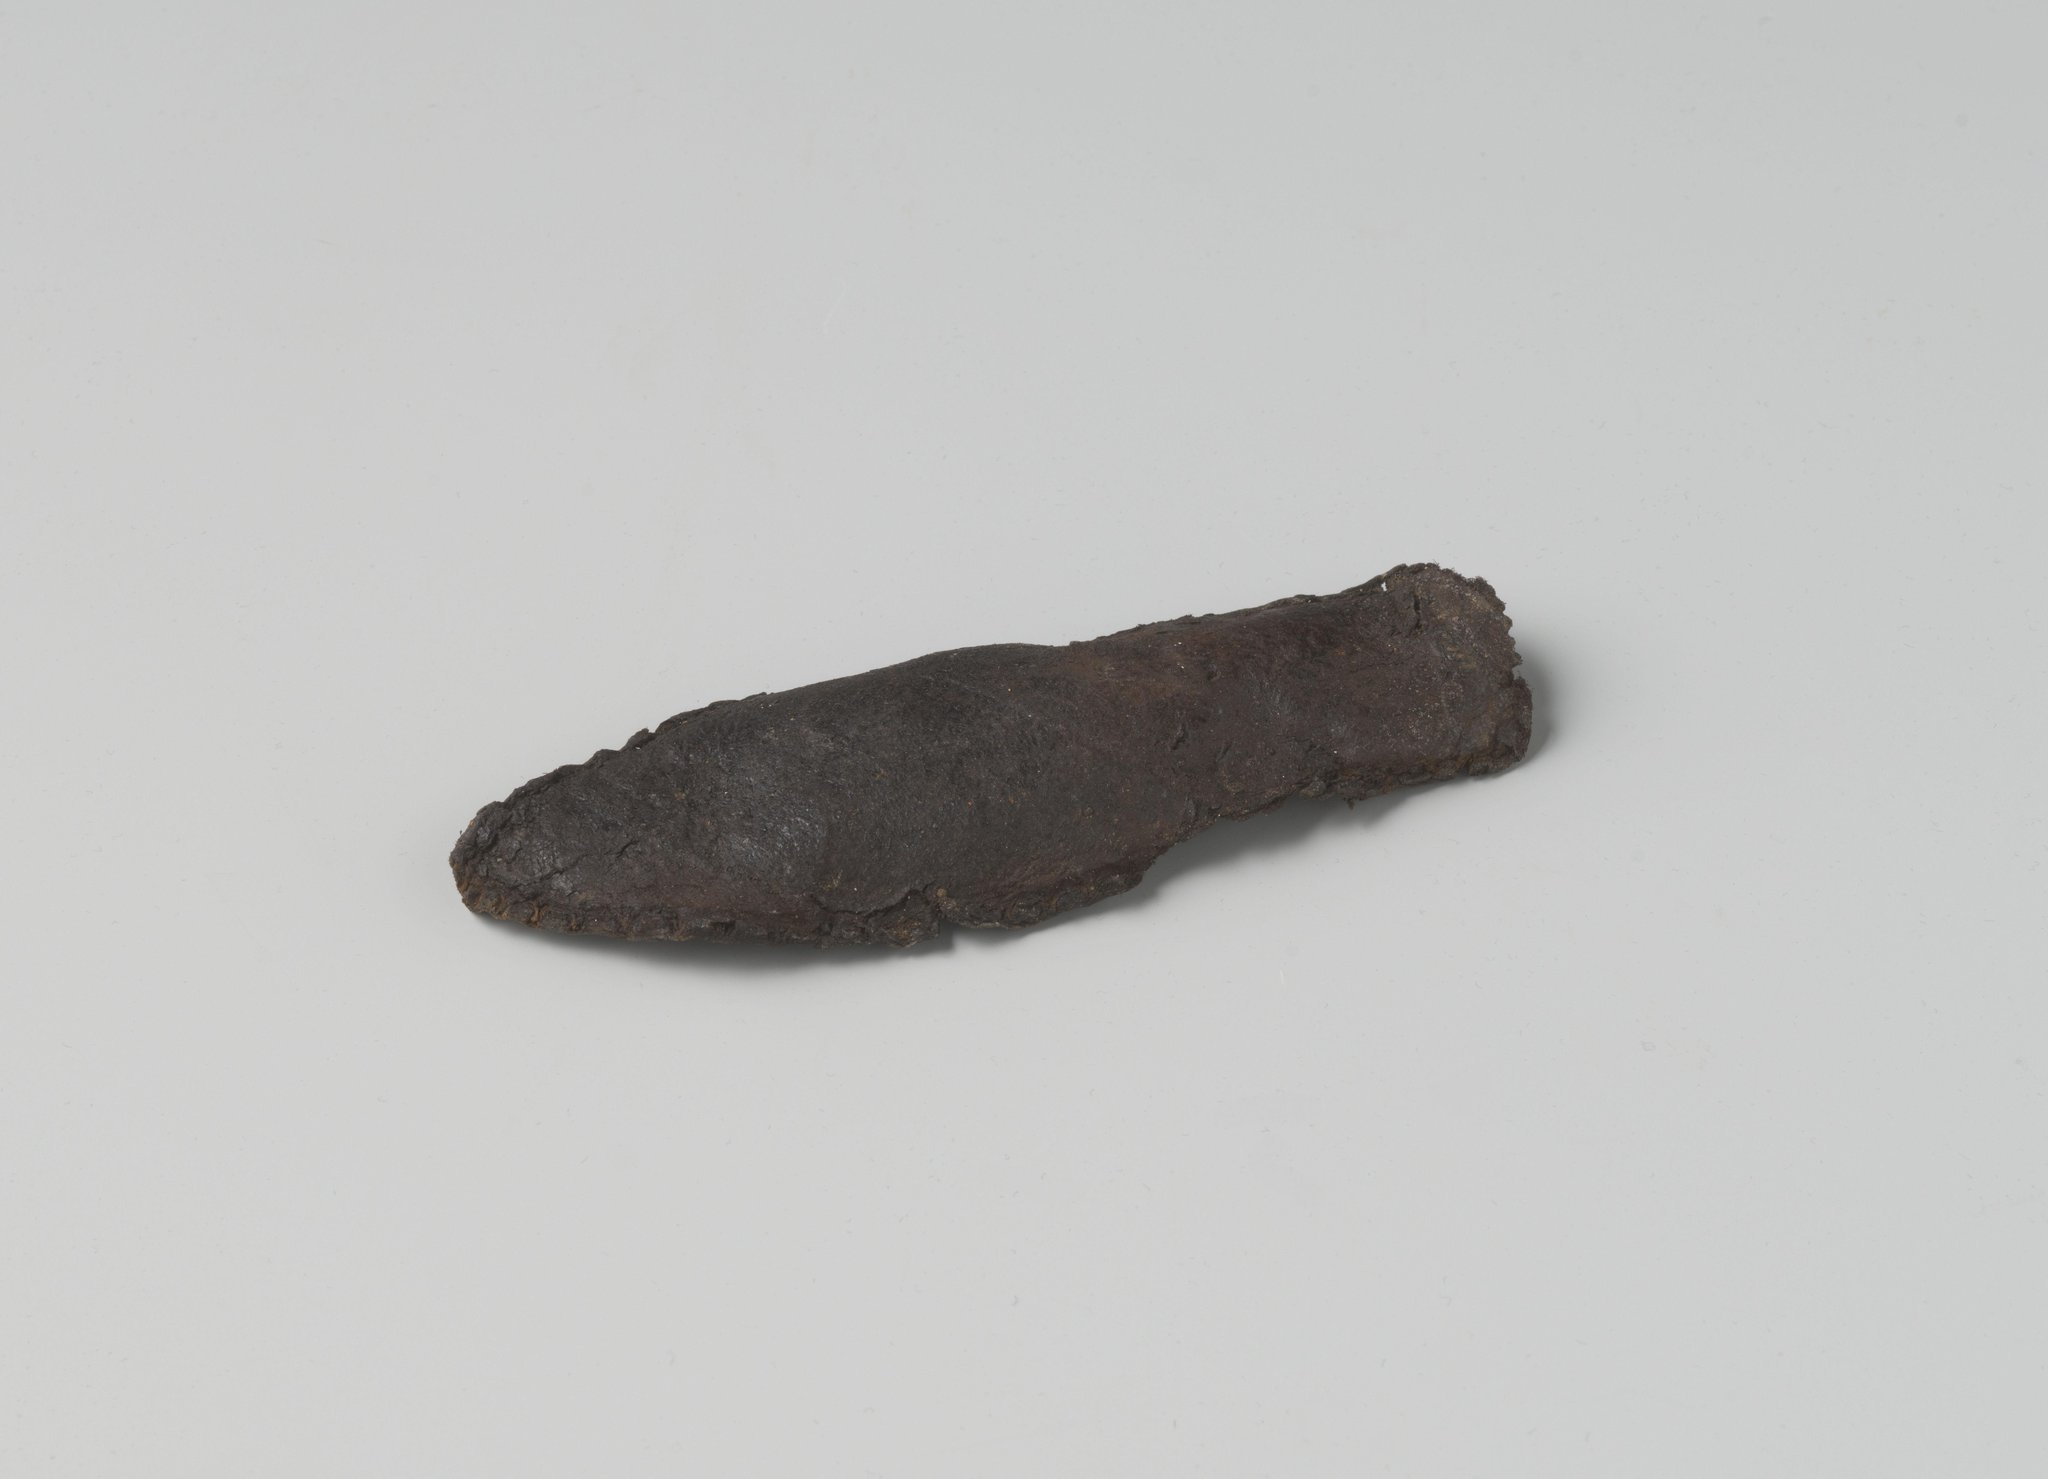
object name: sole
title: Schoenzool uit het wrak van de Oostindiëvaarder Hollandia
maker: Anonymous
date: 1700-1743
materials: leather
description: Schoenzool met stiksels. Klein formaat (kind).